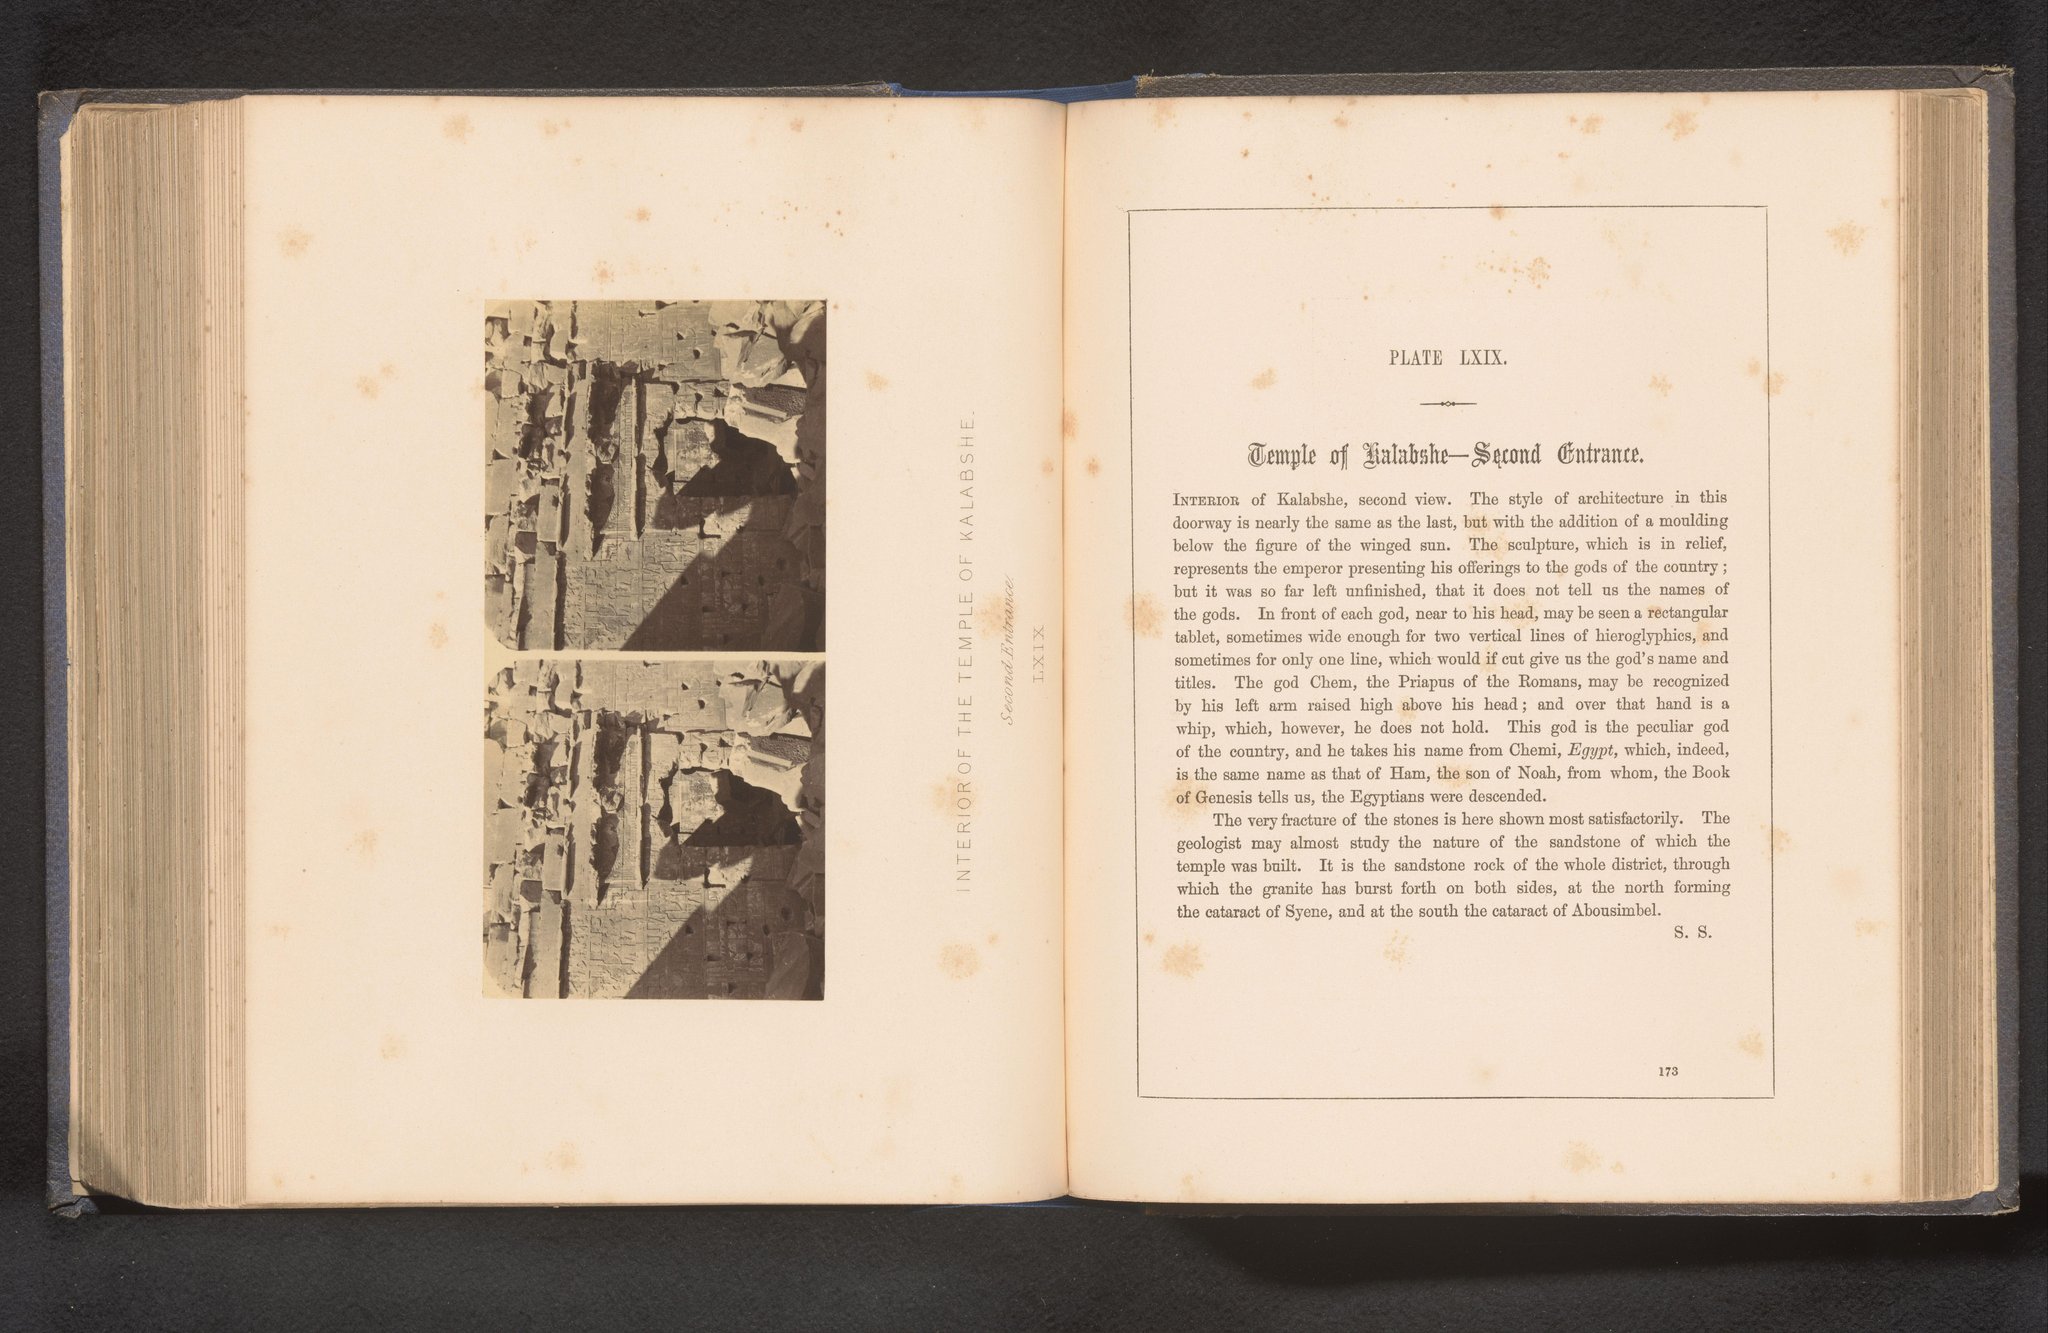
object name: stereograph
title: Interior of the temple of Kalabashe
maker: francis frith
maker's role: publisher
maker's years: 1822-1898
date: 1857-1862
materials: photographic support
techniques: albumen print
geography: egypt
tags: temple, shrine ~ egyptian religion, gate, entrance, egyptian hieroglyphs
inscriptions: name: ‘Frith’, number: ‘LXIX’, inscription: ‘Second Entrance’